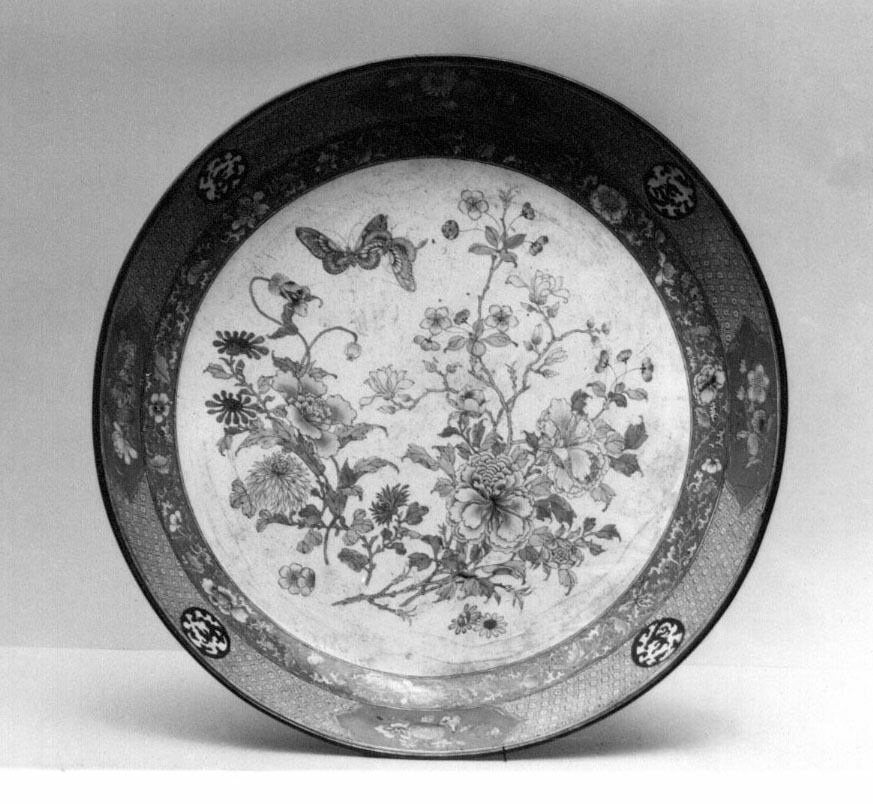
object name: dish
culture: chinese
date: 1736-1795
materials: enamel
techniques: painting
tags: butterflies,flowers,plants